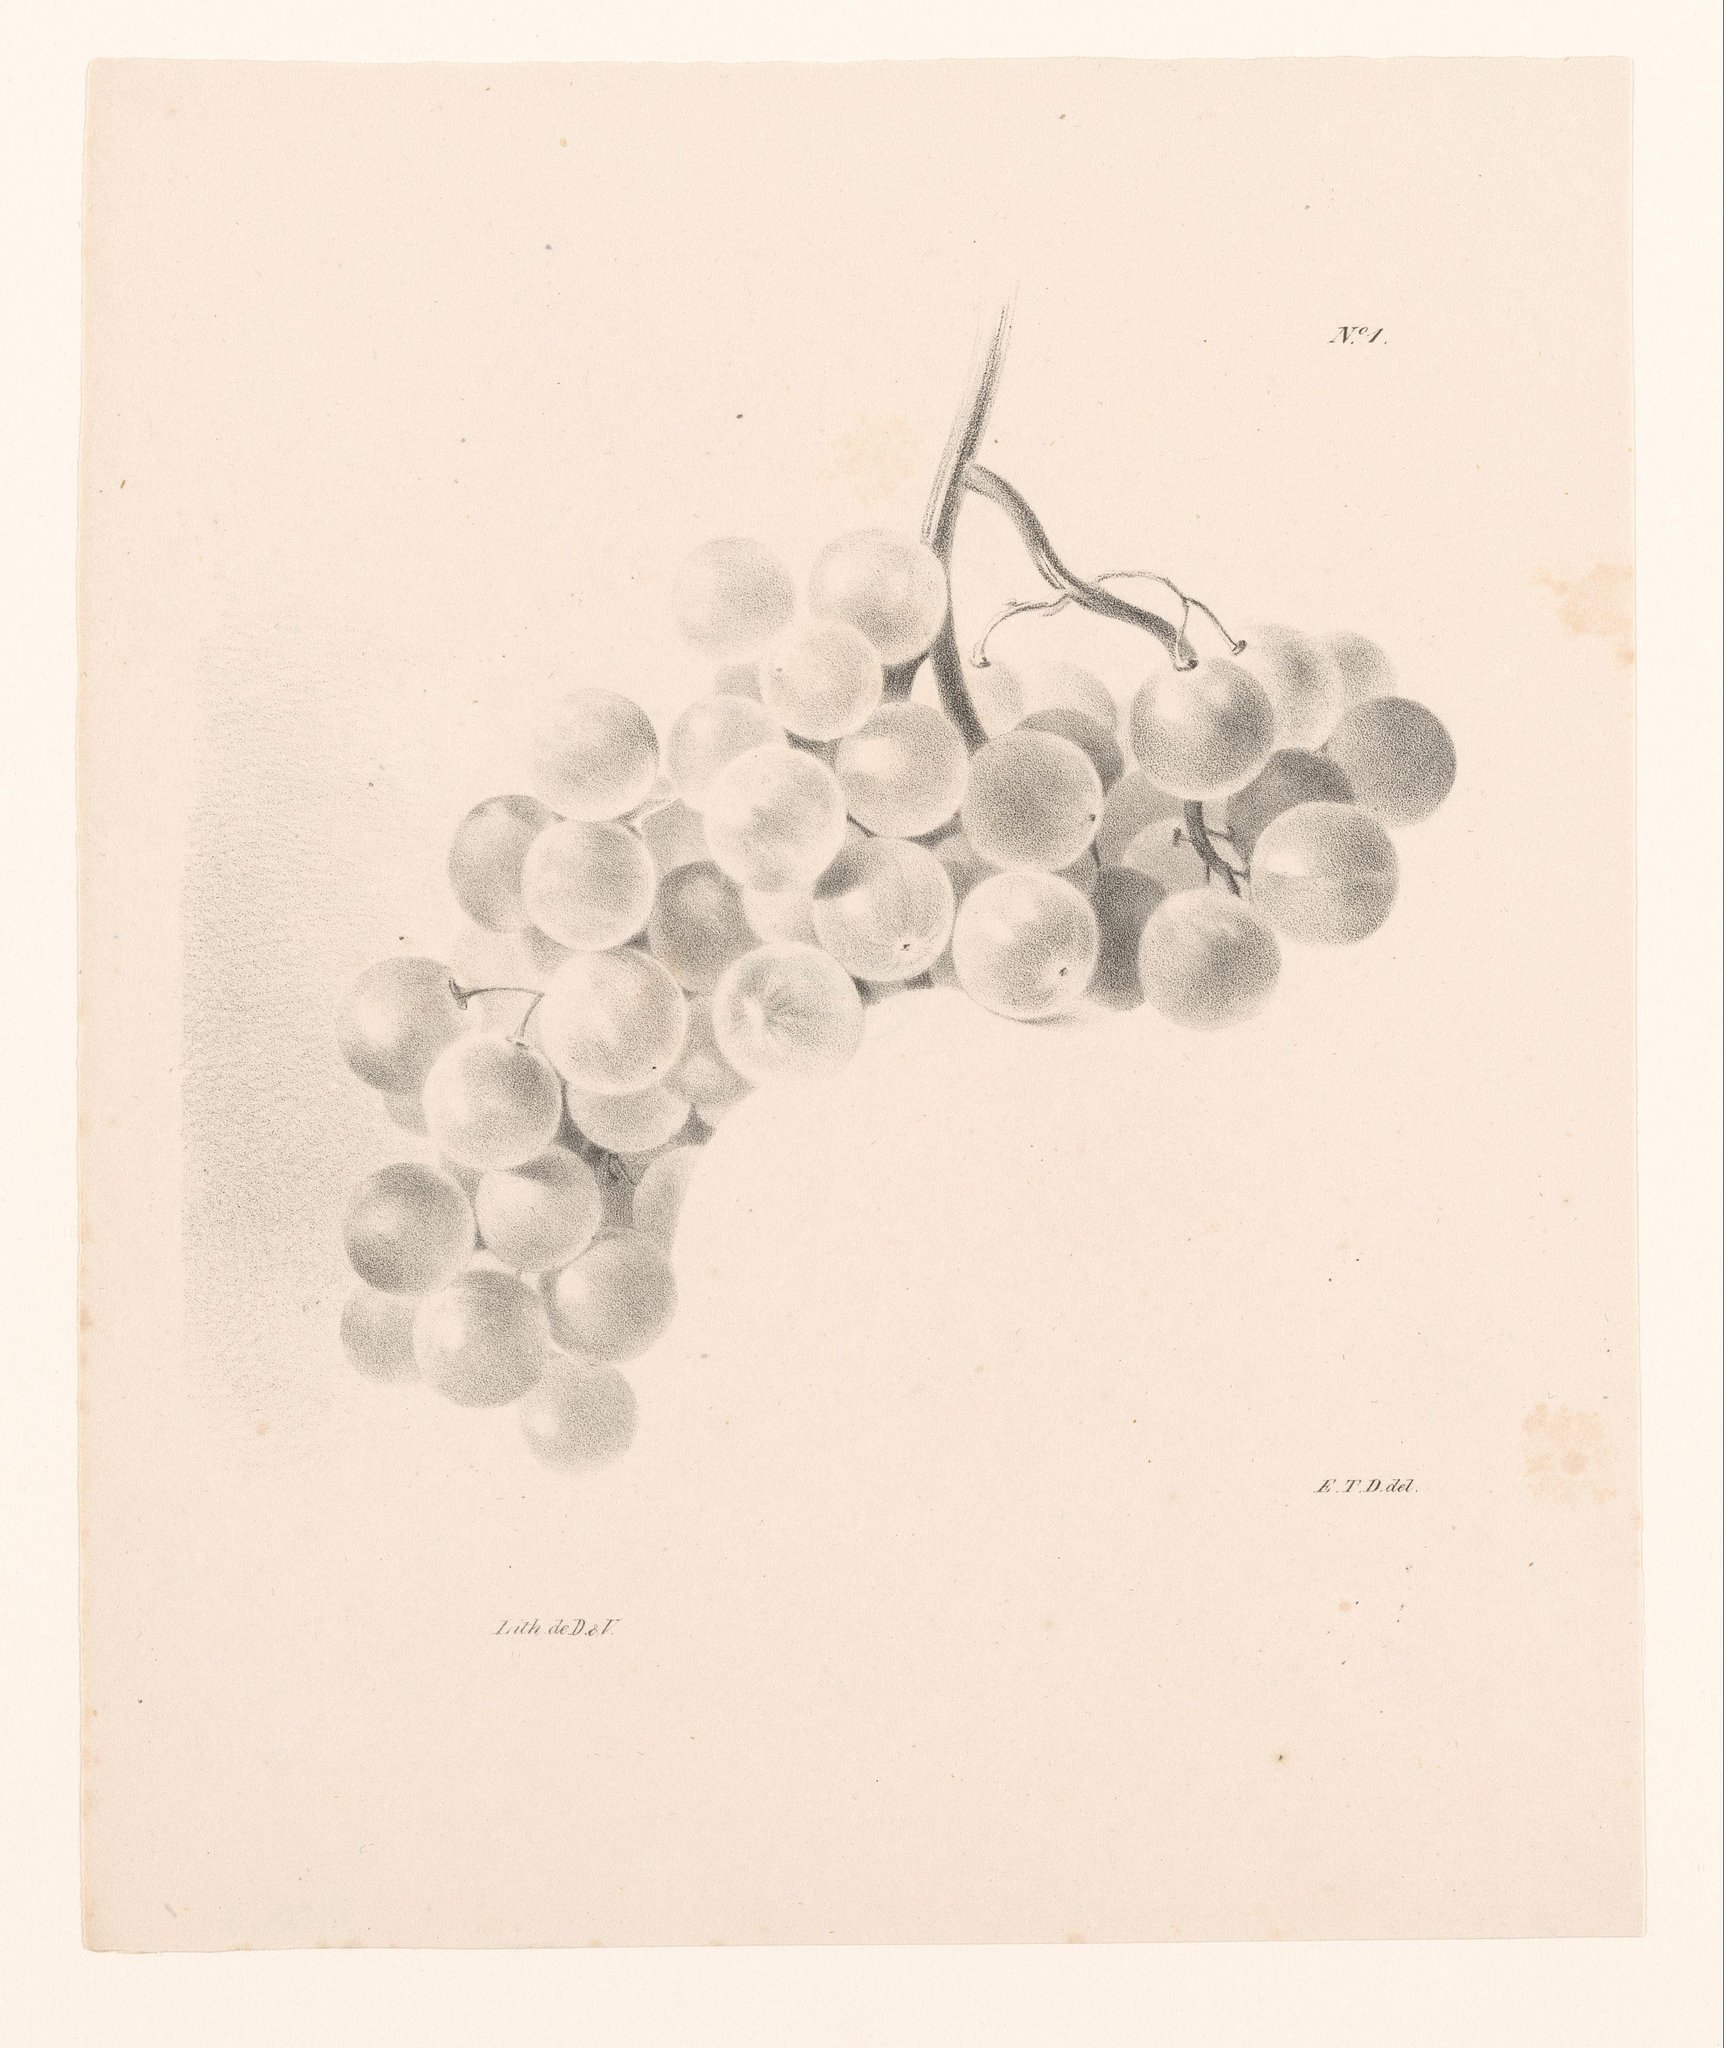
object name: print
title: Principes de Fleurs et de Fruits l'Usage des Commencants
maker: elise therèse daiwaille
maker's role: print maker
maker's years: 1814-1881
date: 1824-1881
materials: paper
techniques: lithograph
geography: amsterdam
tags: bunch of grapes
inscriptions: collector's mark: Lugt 2228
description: Een wit vlak is uitgespaard onder de druiven. Genummerd rechtsboven: 'No. 1'. De prent maakt deel uit van een omslag met zes prenten.